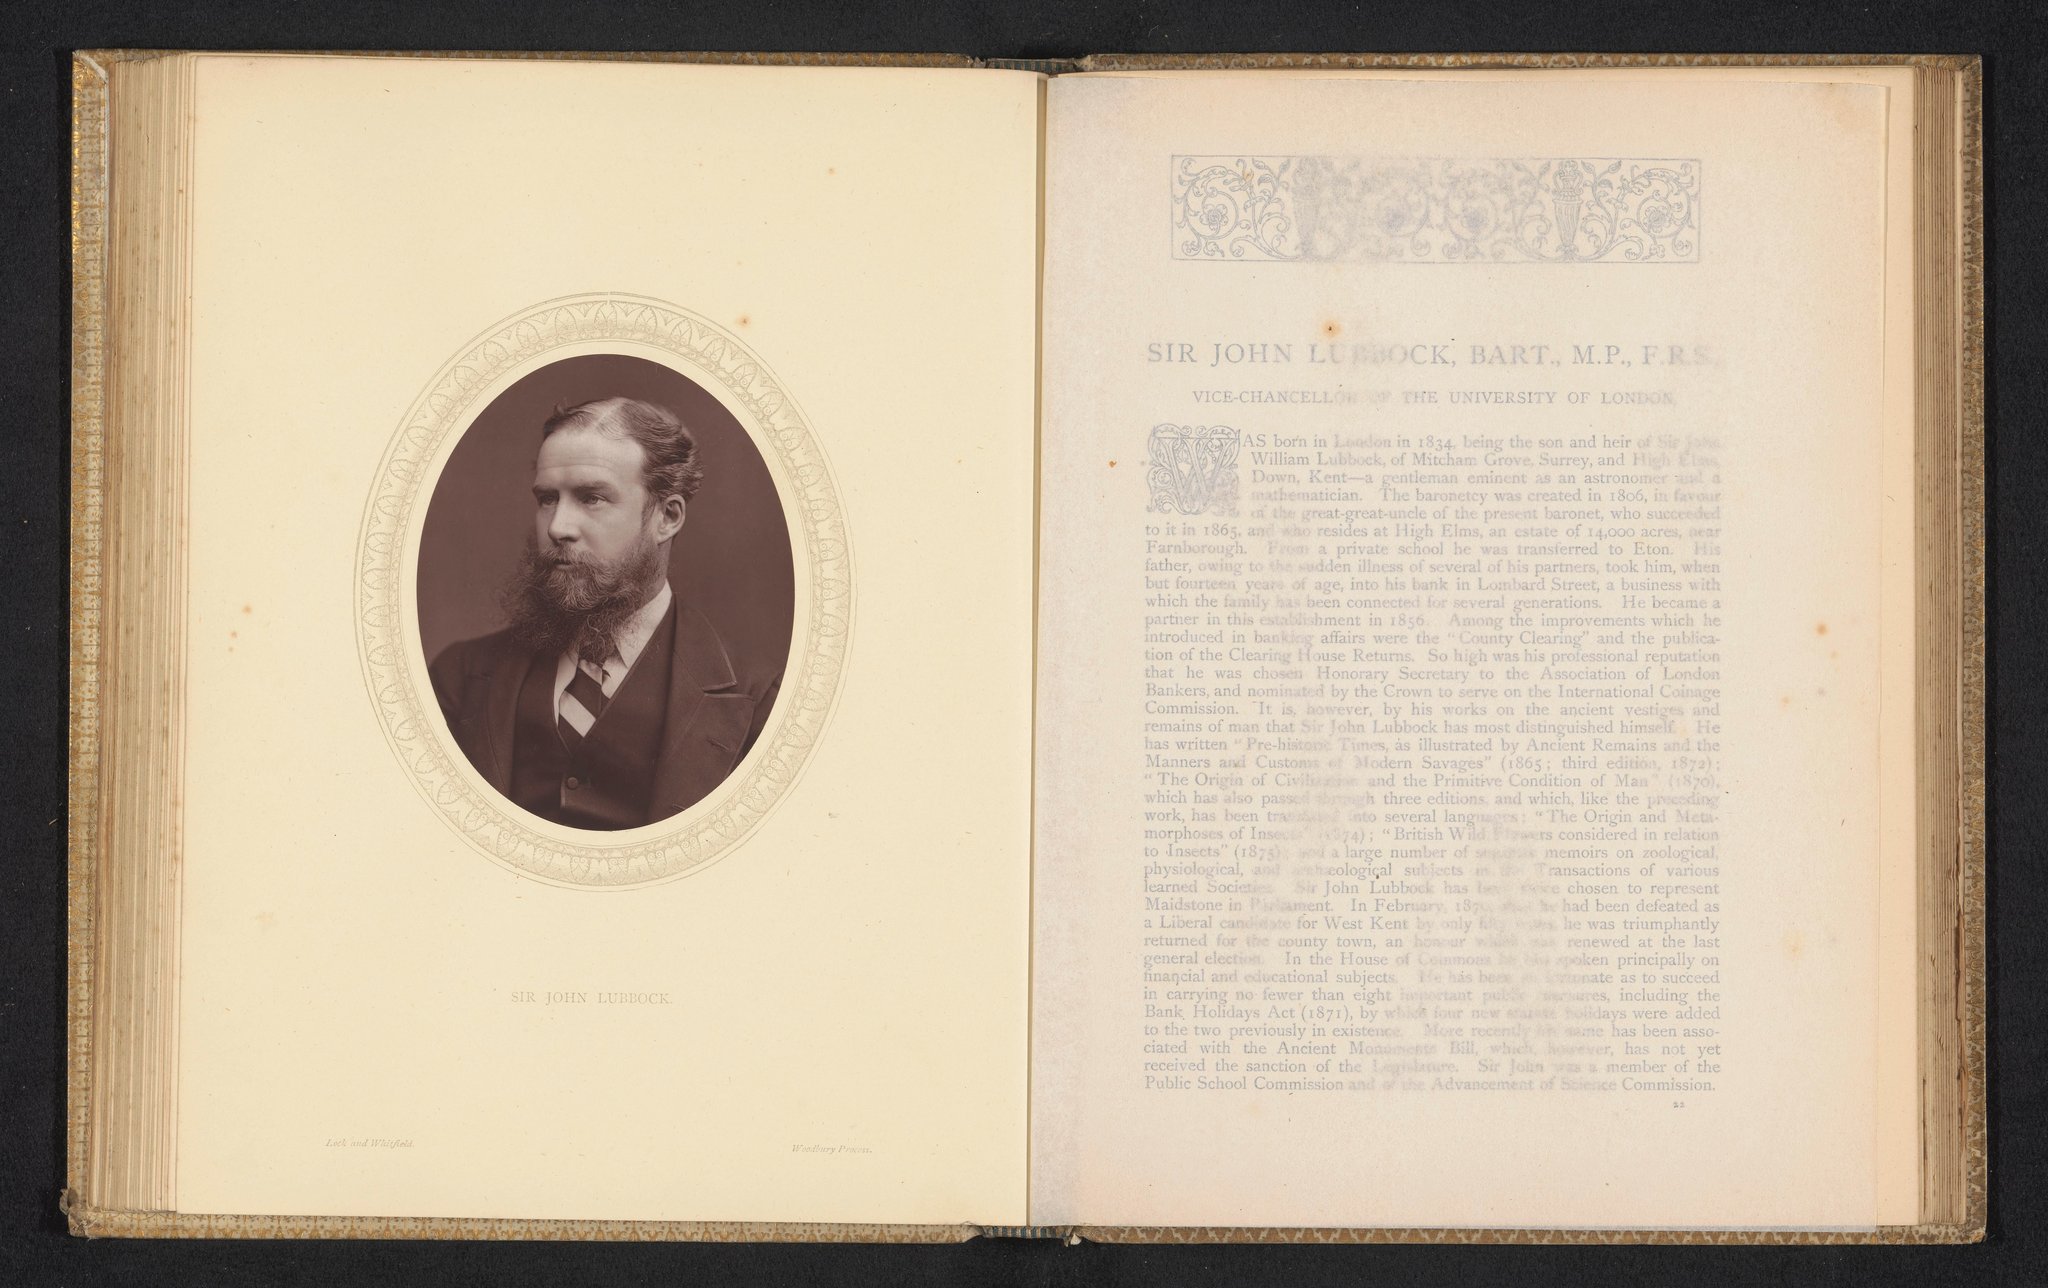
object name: page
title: Sir John Lubbock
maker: Anonymous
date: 1871-1876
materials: paper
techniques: woodburytype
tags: banker, historical persons (portraits and scenes from the life) (+ (full) bust portrait)